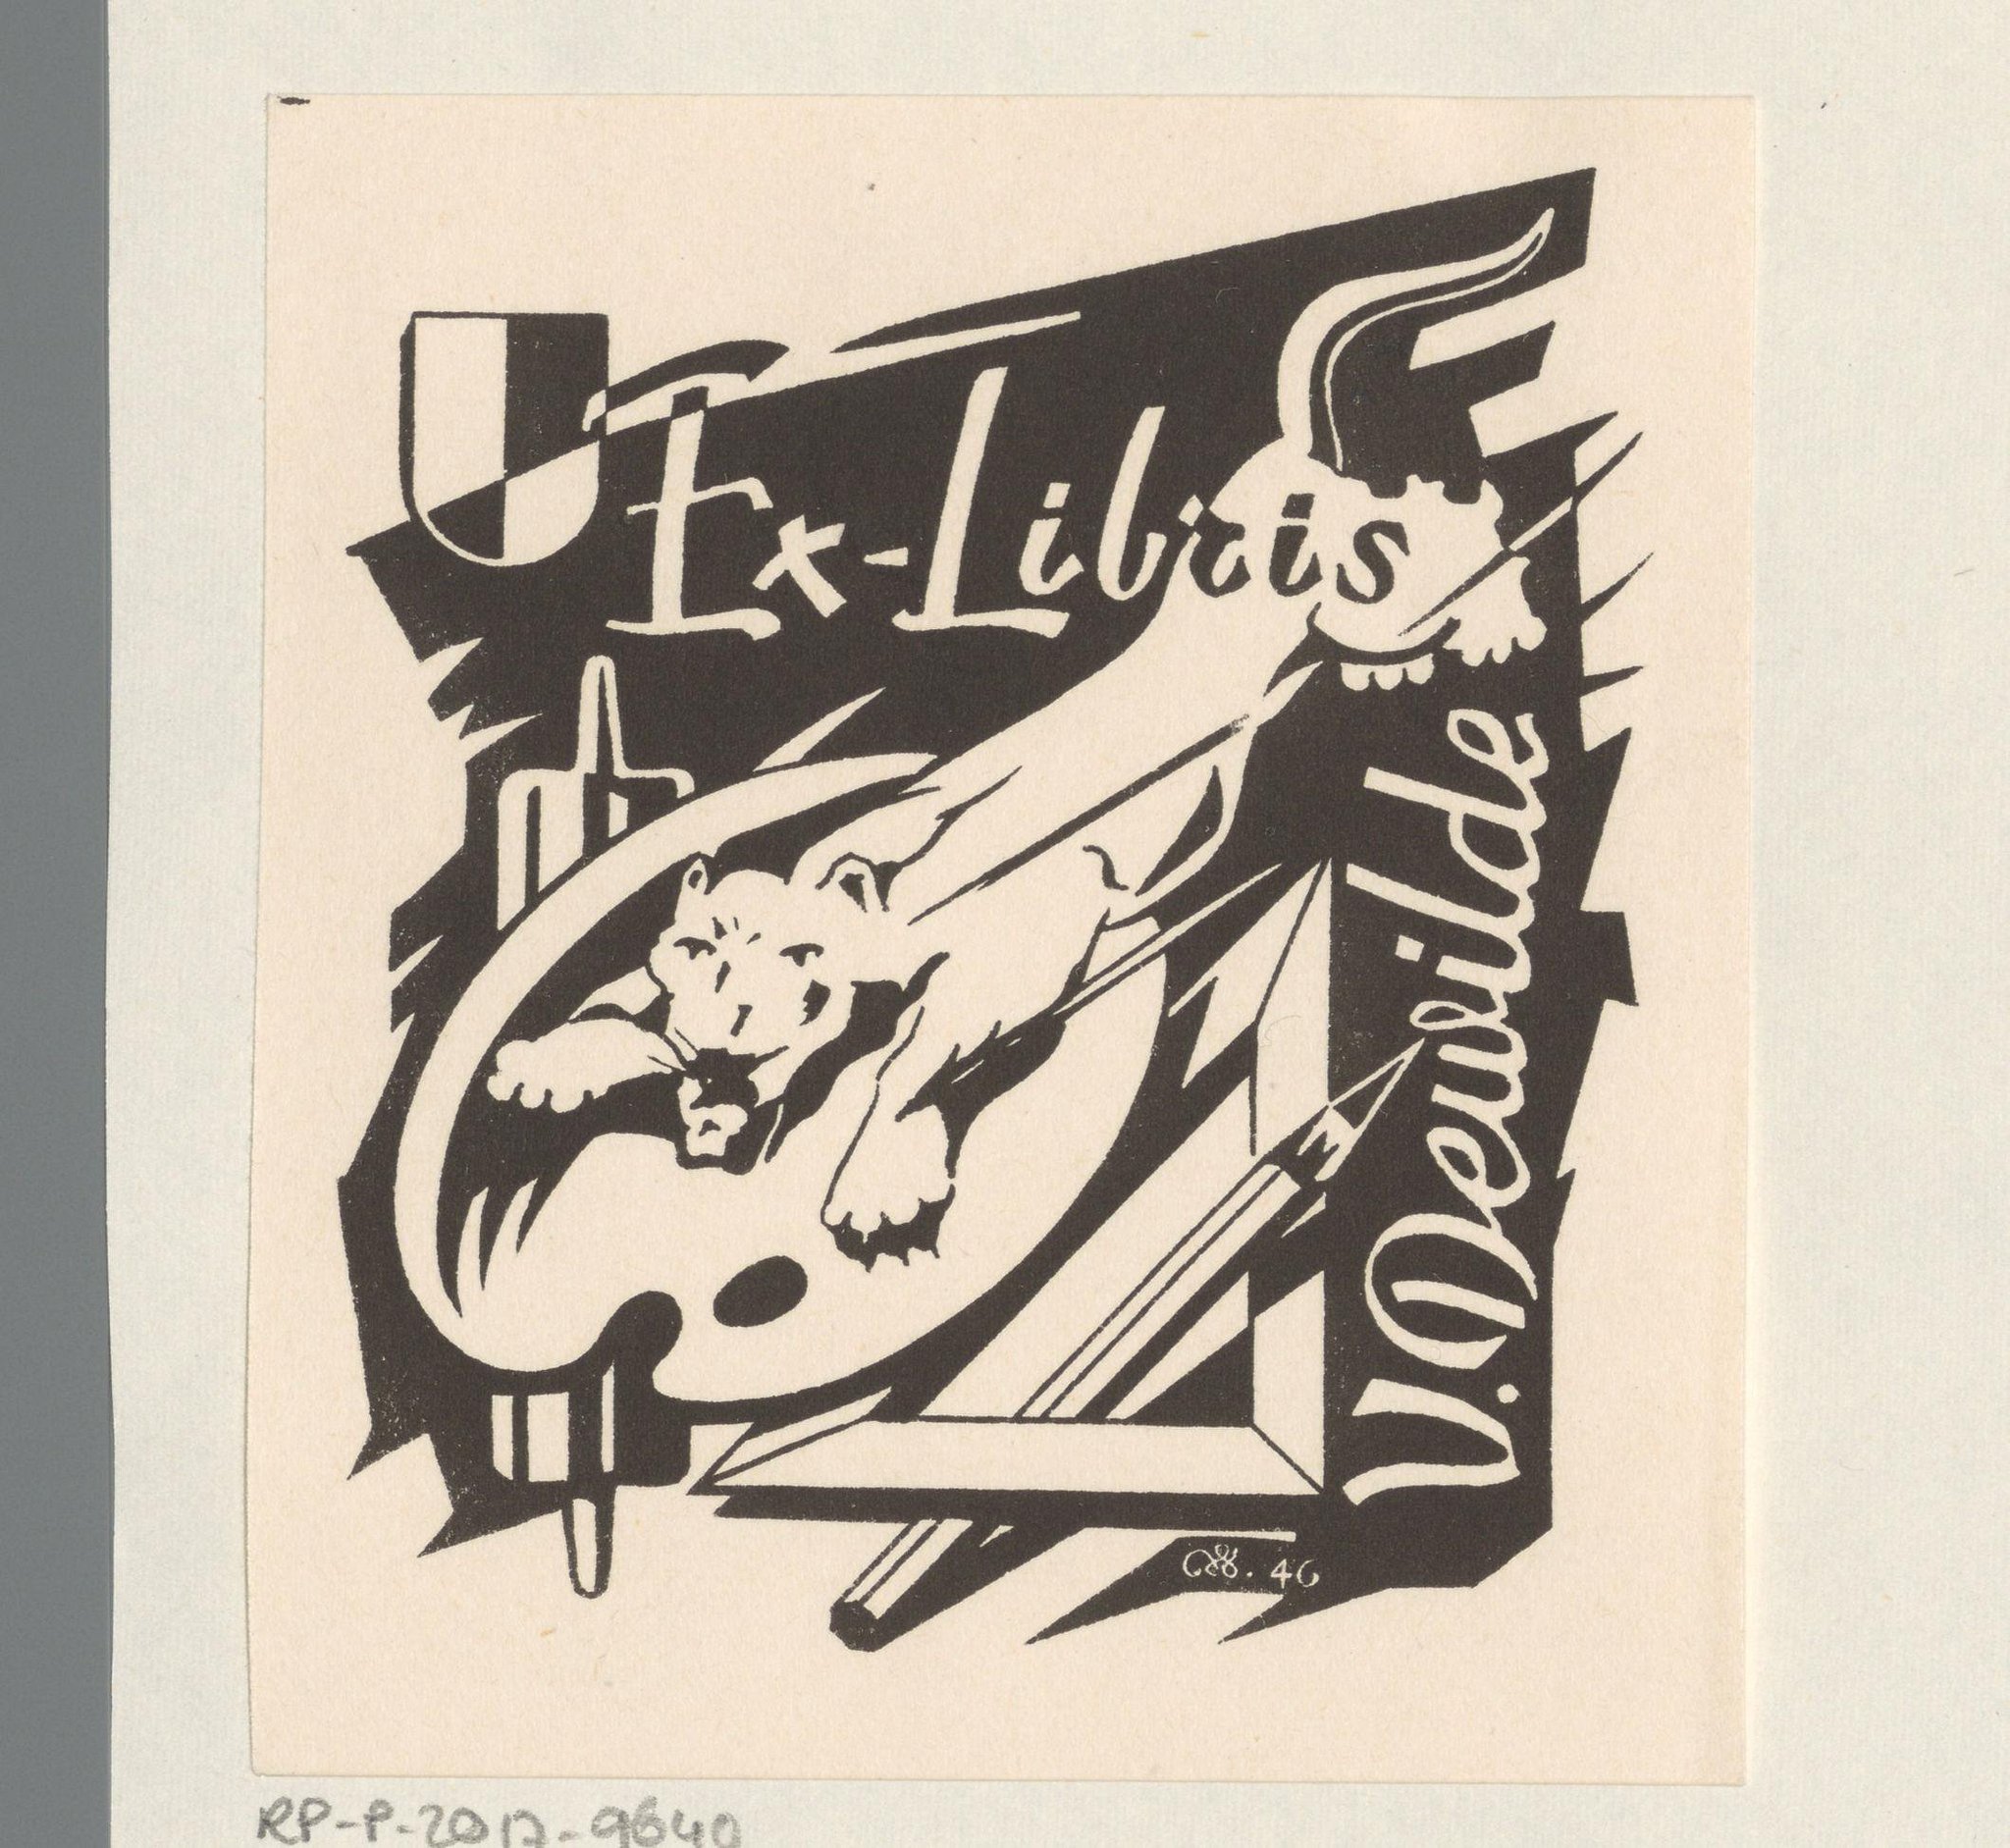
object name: bookplate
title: Ex libris van V. Dewilde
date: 1946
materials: paper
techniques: printing block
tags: palette, beasts of prey, predatory animals: lion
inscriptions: date